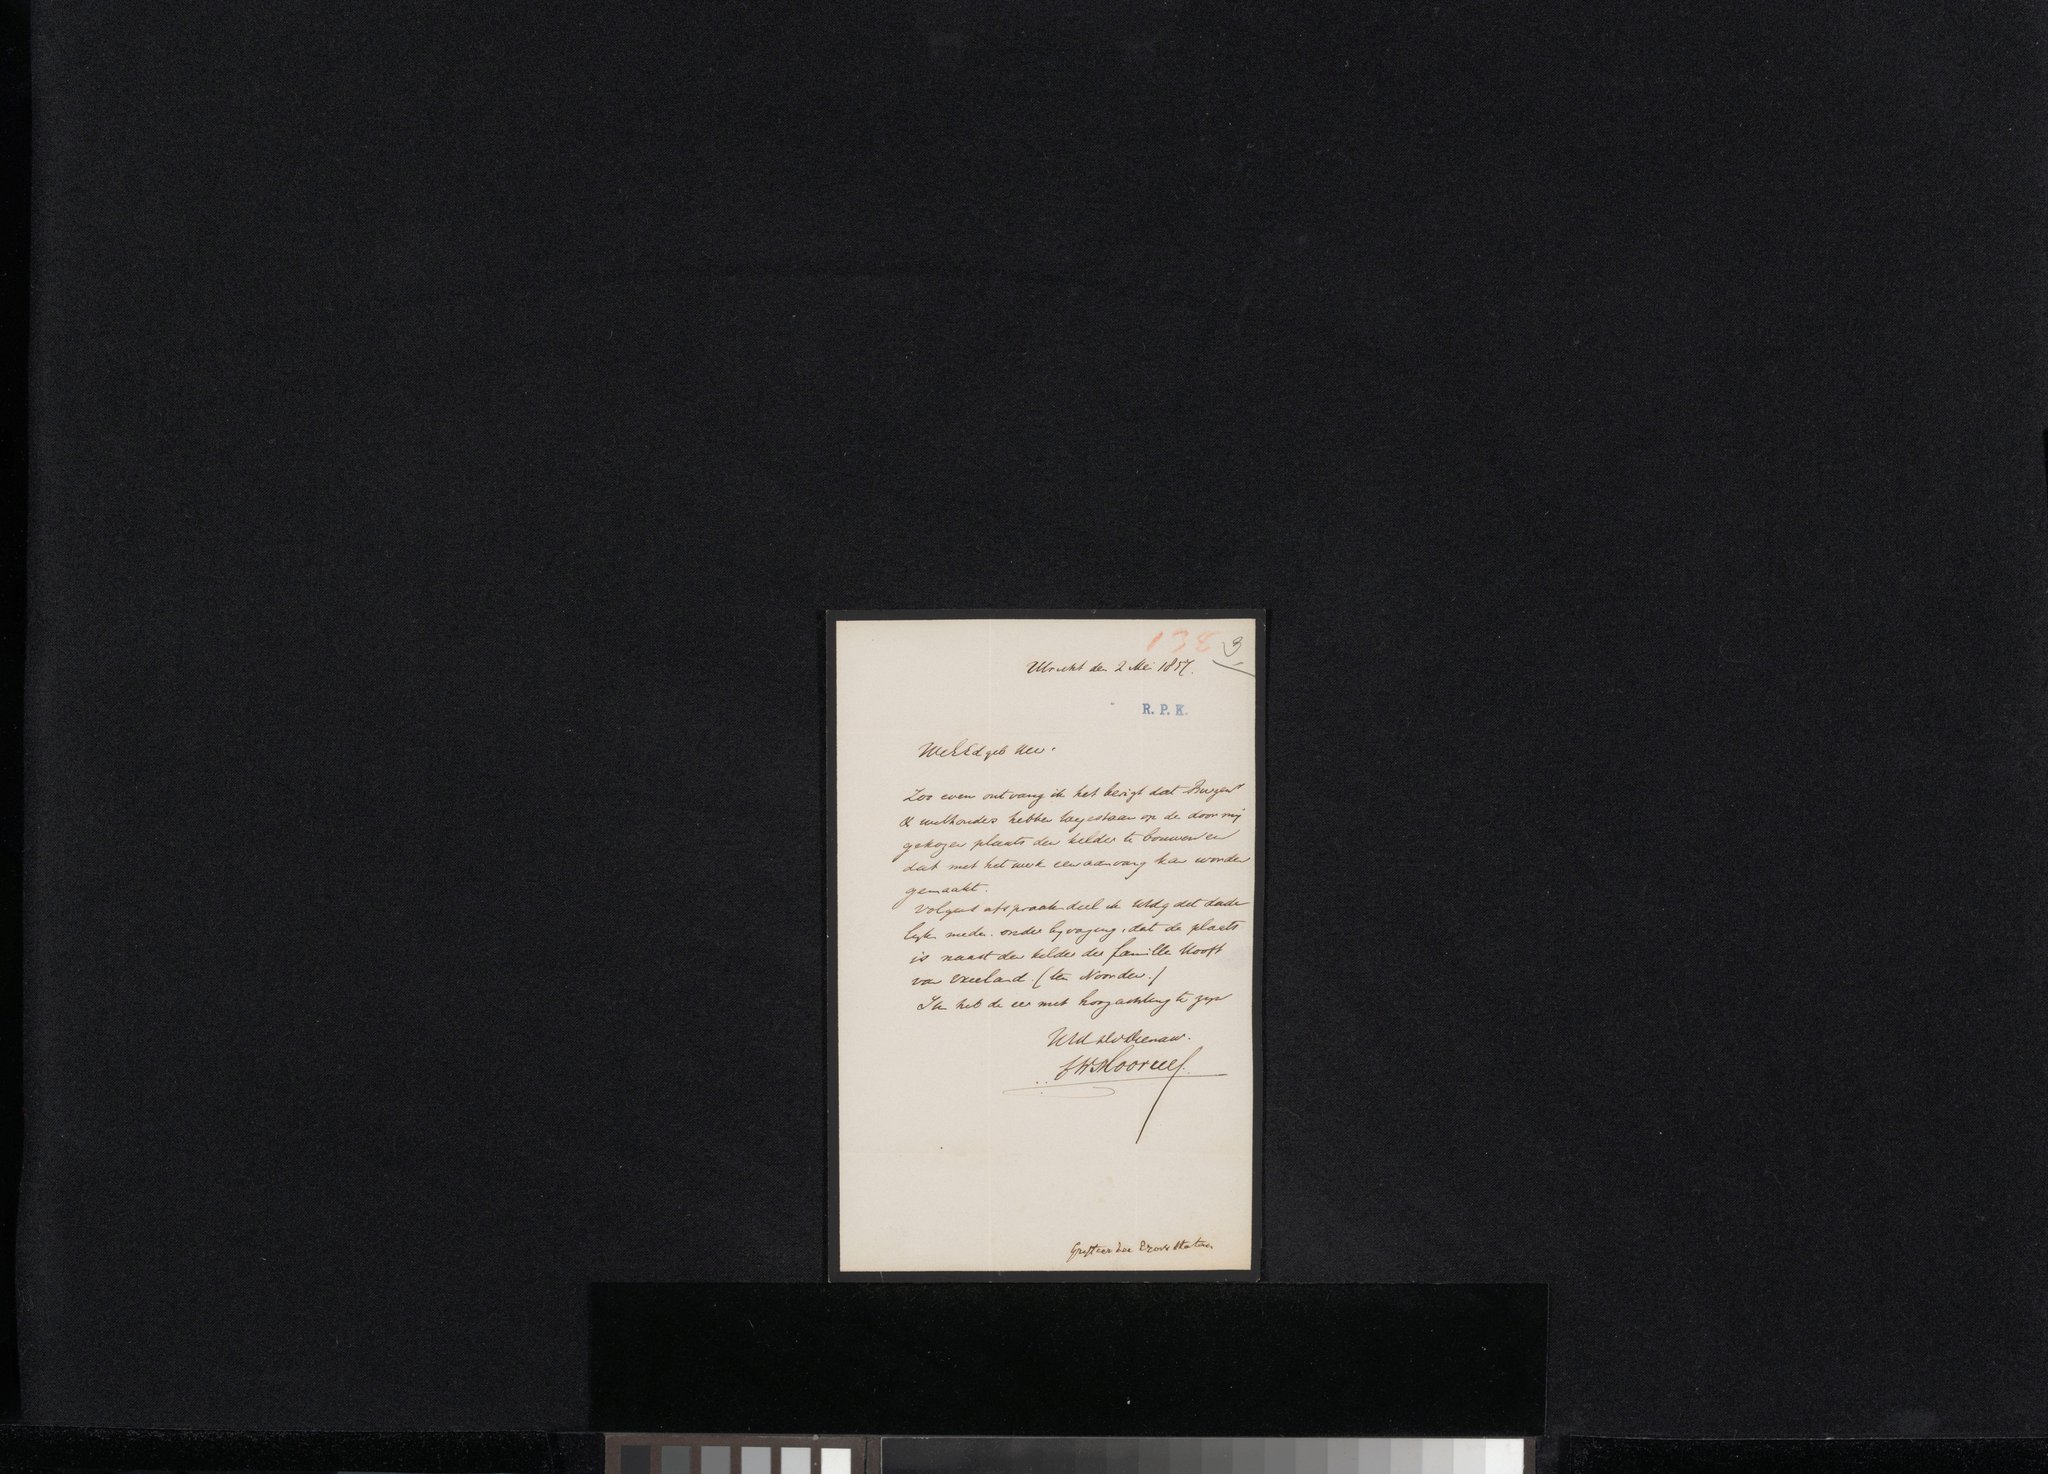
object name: letter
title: Brief aan Christiaan Kramm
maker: christiaan wilhelmus moorrees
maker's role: draughtsman, print maker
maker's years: 1801-1867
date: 1857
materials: ink, paper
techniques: pen, writing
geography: utrecht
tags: utrecht, print maker, draughtsman, christiaan kramm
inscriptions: collector's mark: Lugt 2233